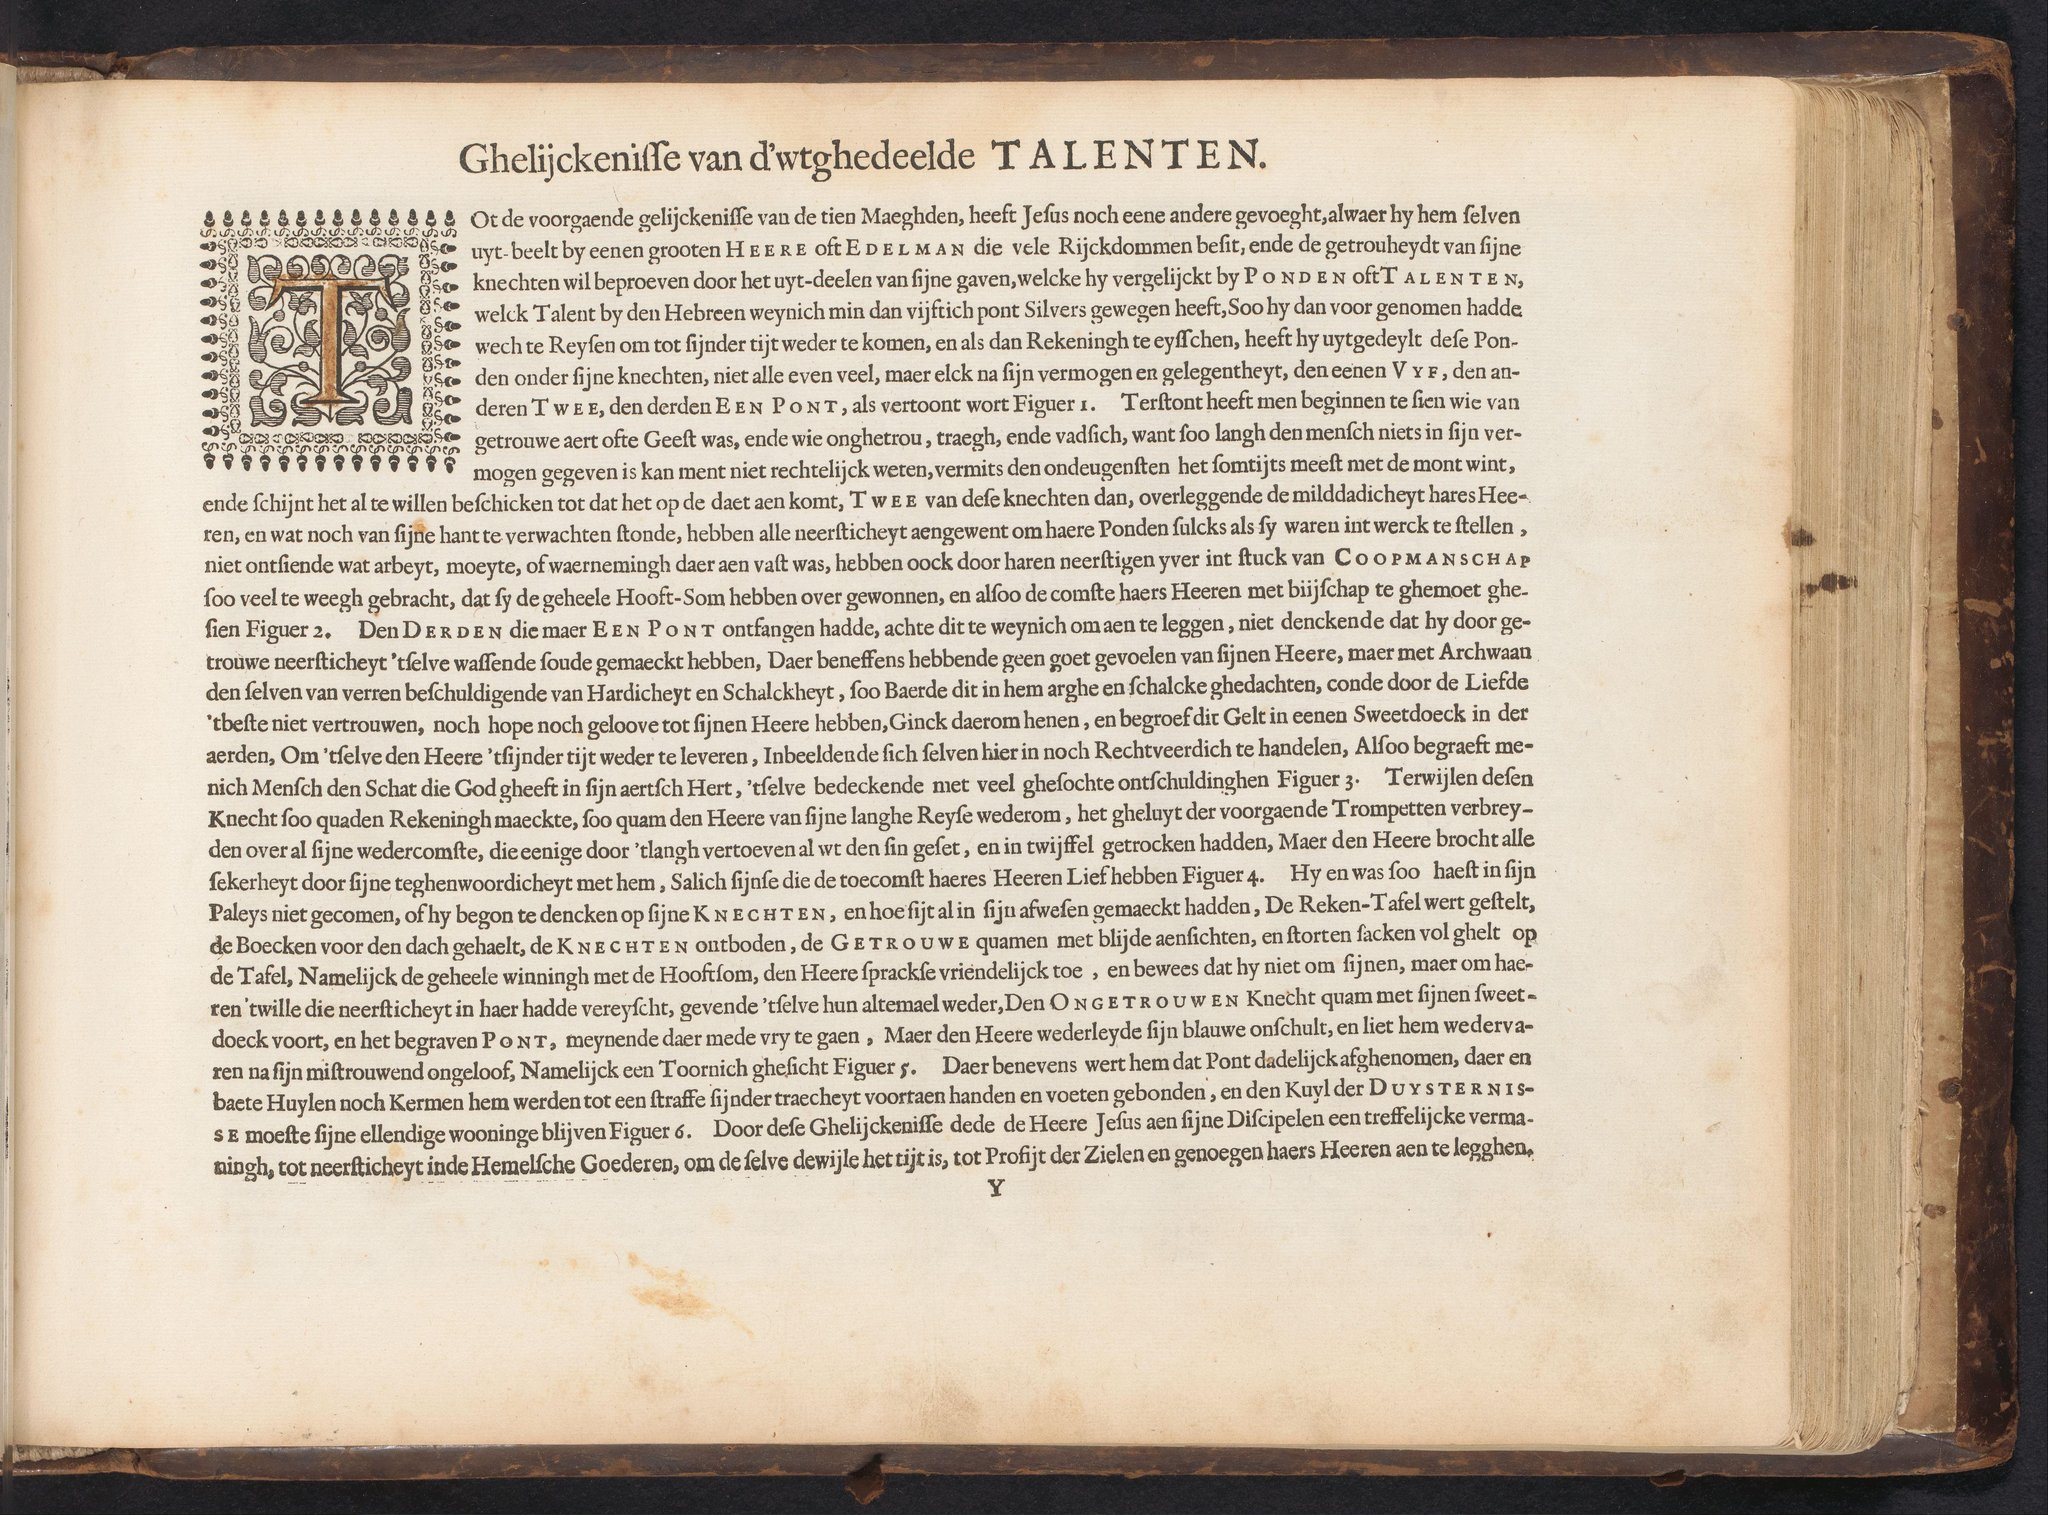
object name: text sheet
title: Ghelijckenisse van d'wtghedeelde Talenten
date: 1646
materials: paper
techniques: hand coloring, letterpress printing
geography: alkmaar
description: Tekstblad bij een serie prenten over de gelijkenis van de talenten. Linksboven initiaal T. Dit blad maakt deel uit van een album.